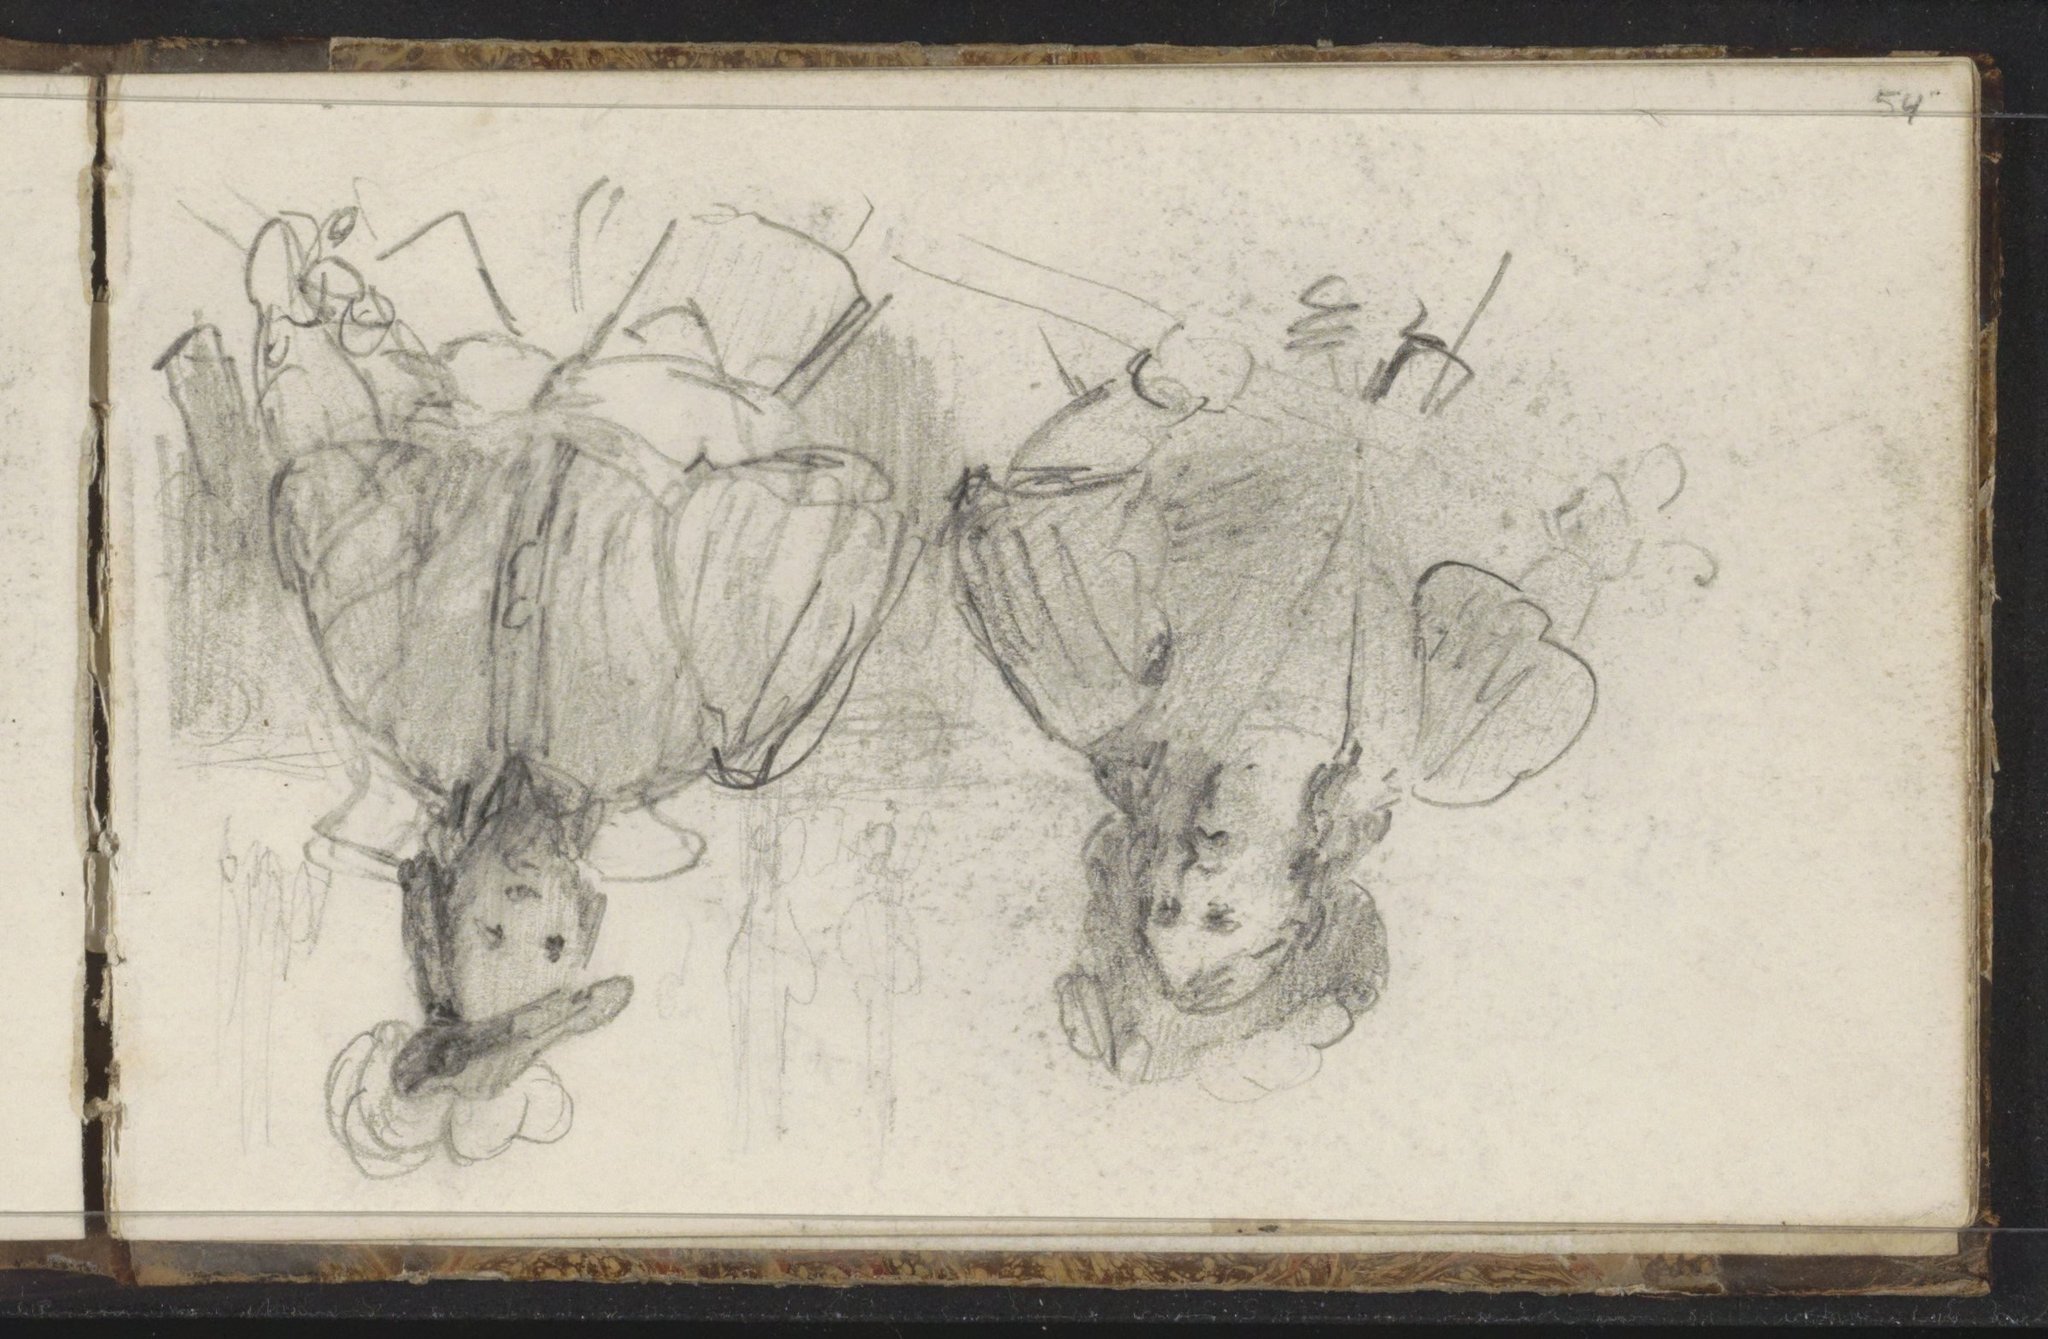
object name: sketchbook leaf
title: Twee mannen met zwaarden in historisch kostuum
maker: willem hendrik schmidt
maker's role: draughtsman, painter, print maker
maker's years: 1809-1849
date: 1819-1849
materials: paper, pencil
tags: historical costume (+ men's clothes), hacking and thrusting weapons: sword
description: Blad 54 recto uit een schetsboek met 60 bladen.